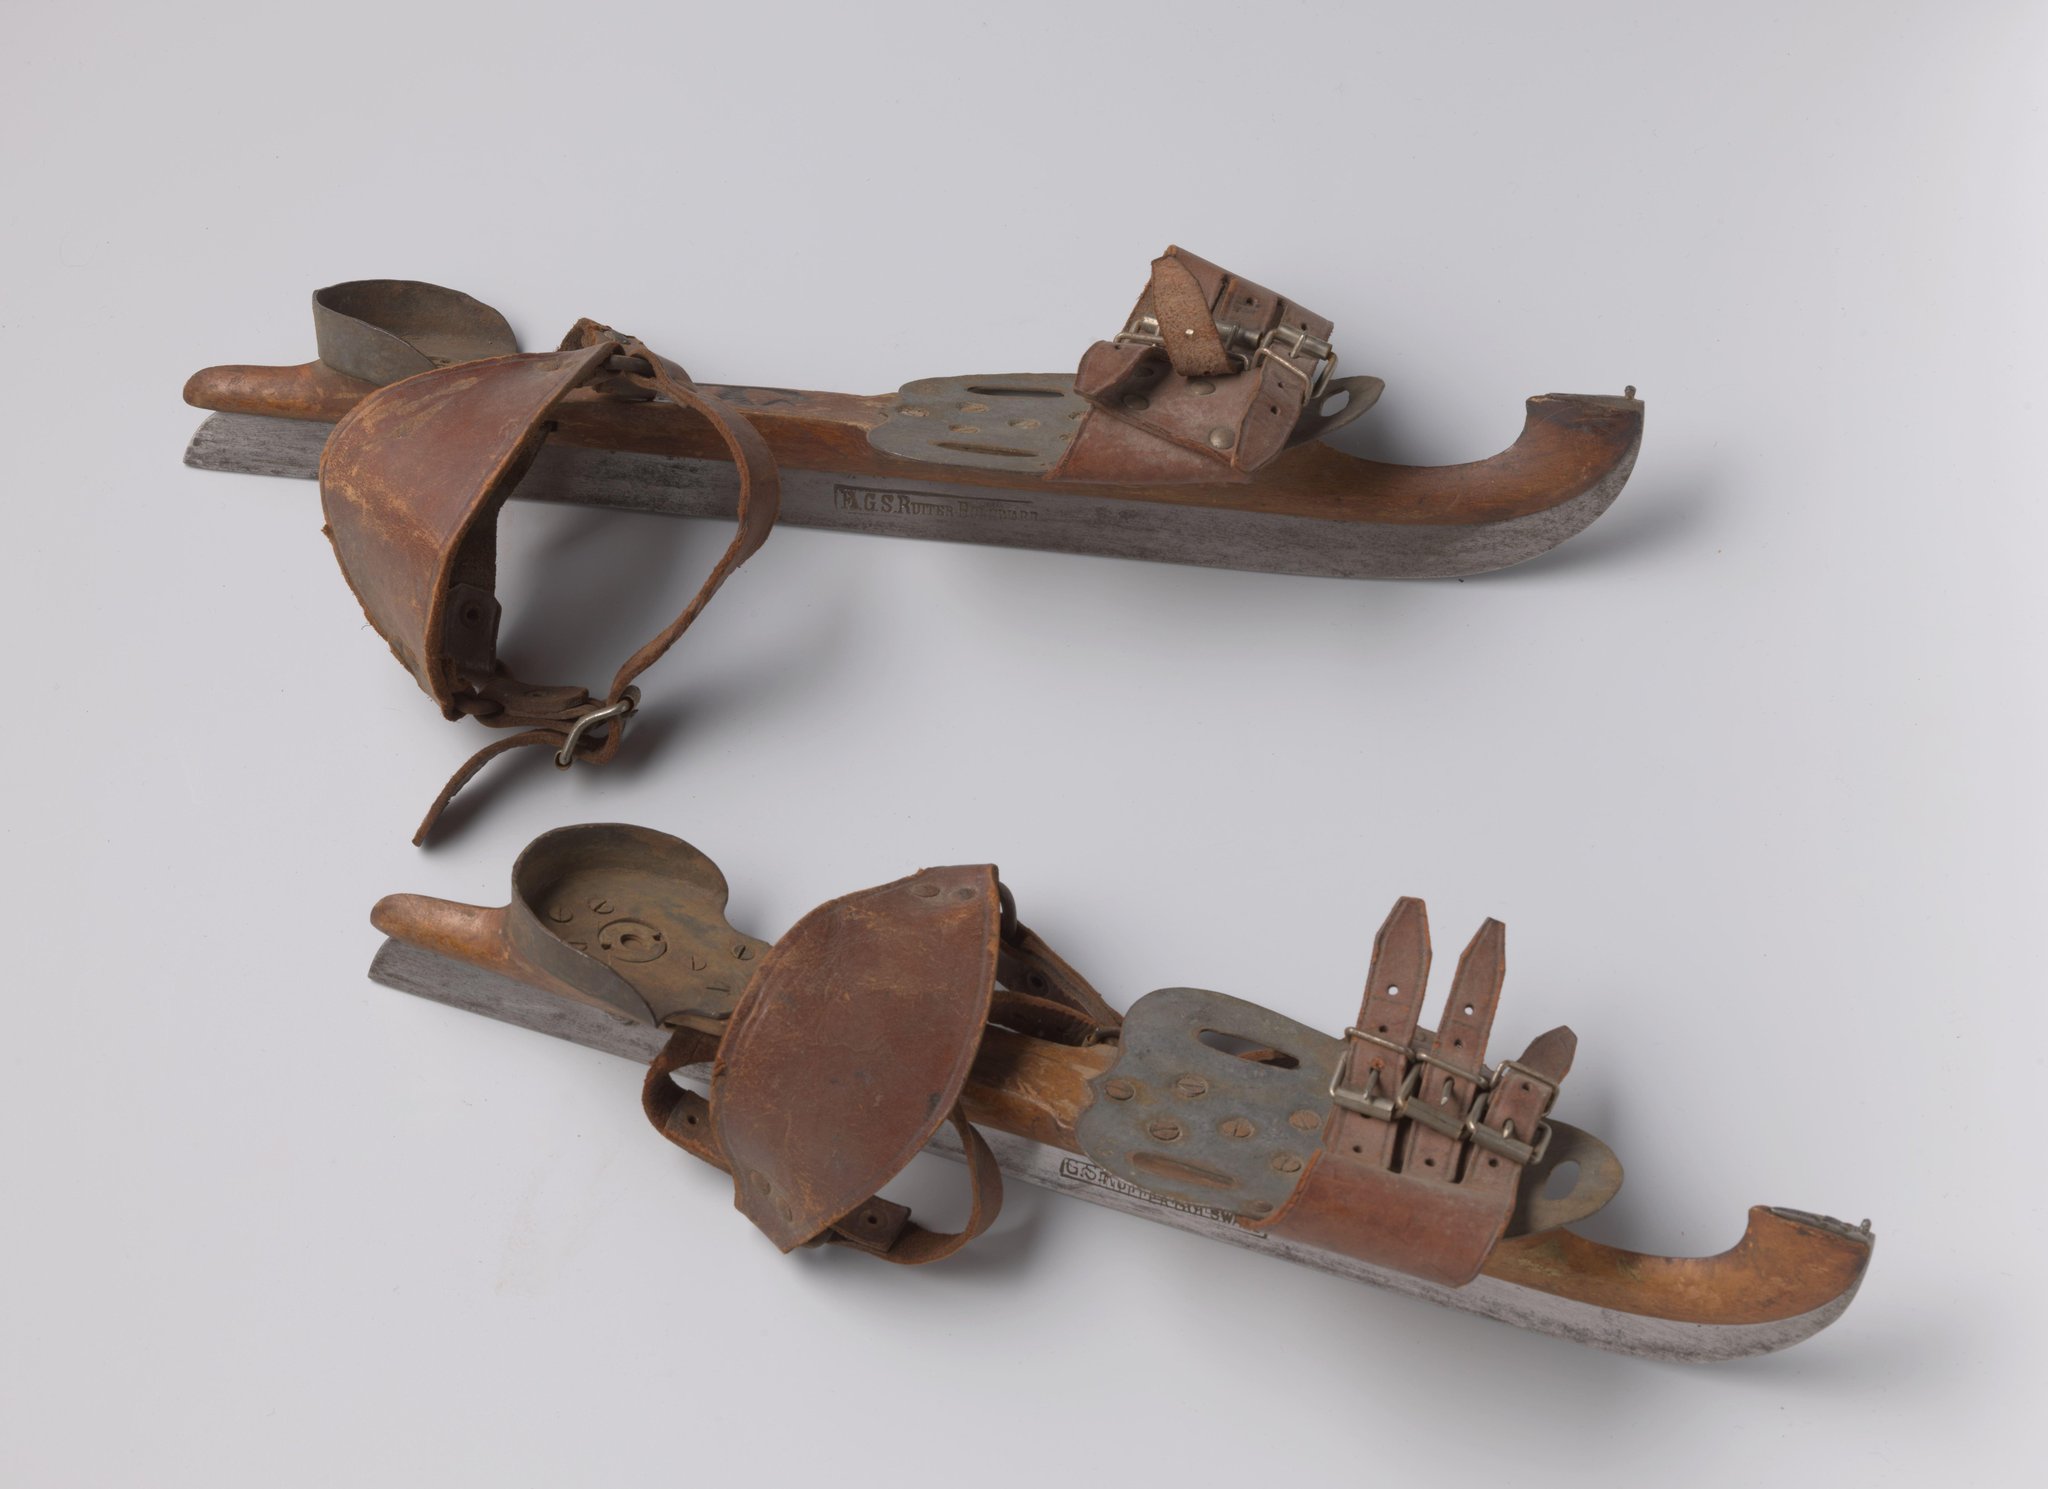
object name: skate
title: Vissering-Ruiter of Koninginneschaats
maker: gerard vissering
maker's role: designer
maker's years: 1865-1937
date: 1891-1955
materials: copper, iron, leather, wood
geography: friesland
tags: the hague, print maker, wilhelmina of the netherlands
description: De firma Ruiter leverde een vergelijkbare schaats in 1895 'op order' aan koningin-moeder Emma. Prinses Wilhelmina reed er graag op. Nadat Wilhelmina in 1898 koningin werd en zij dit model in 1899 en 1900 opnieuwe bestelde bij Ruiter kreeg de schaat de naam Koninginneschaats. Overigens wenste de koningin dat de schaatsen voorzien zouden zijn van geelkoperen voetplaten en niet van roodkoper zoals Ruiter bedoeld had.